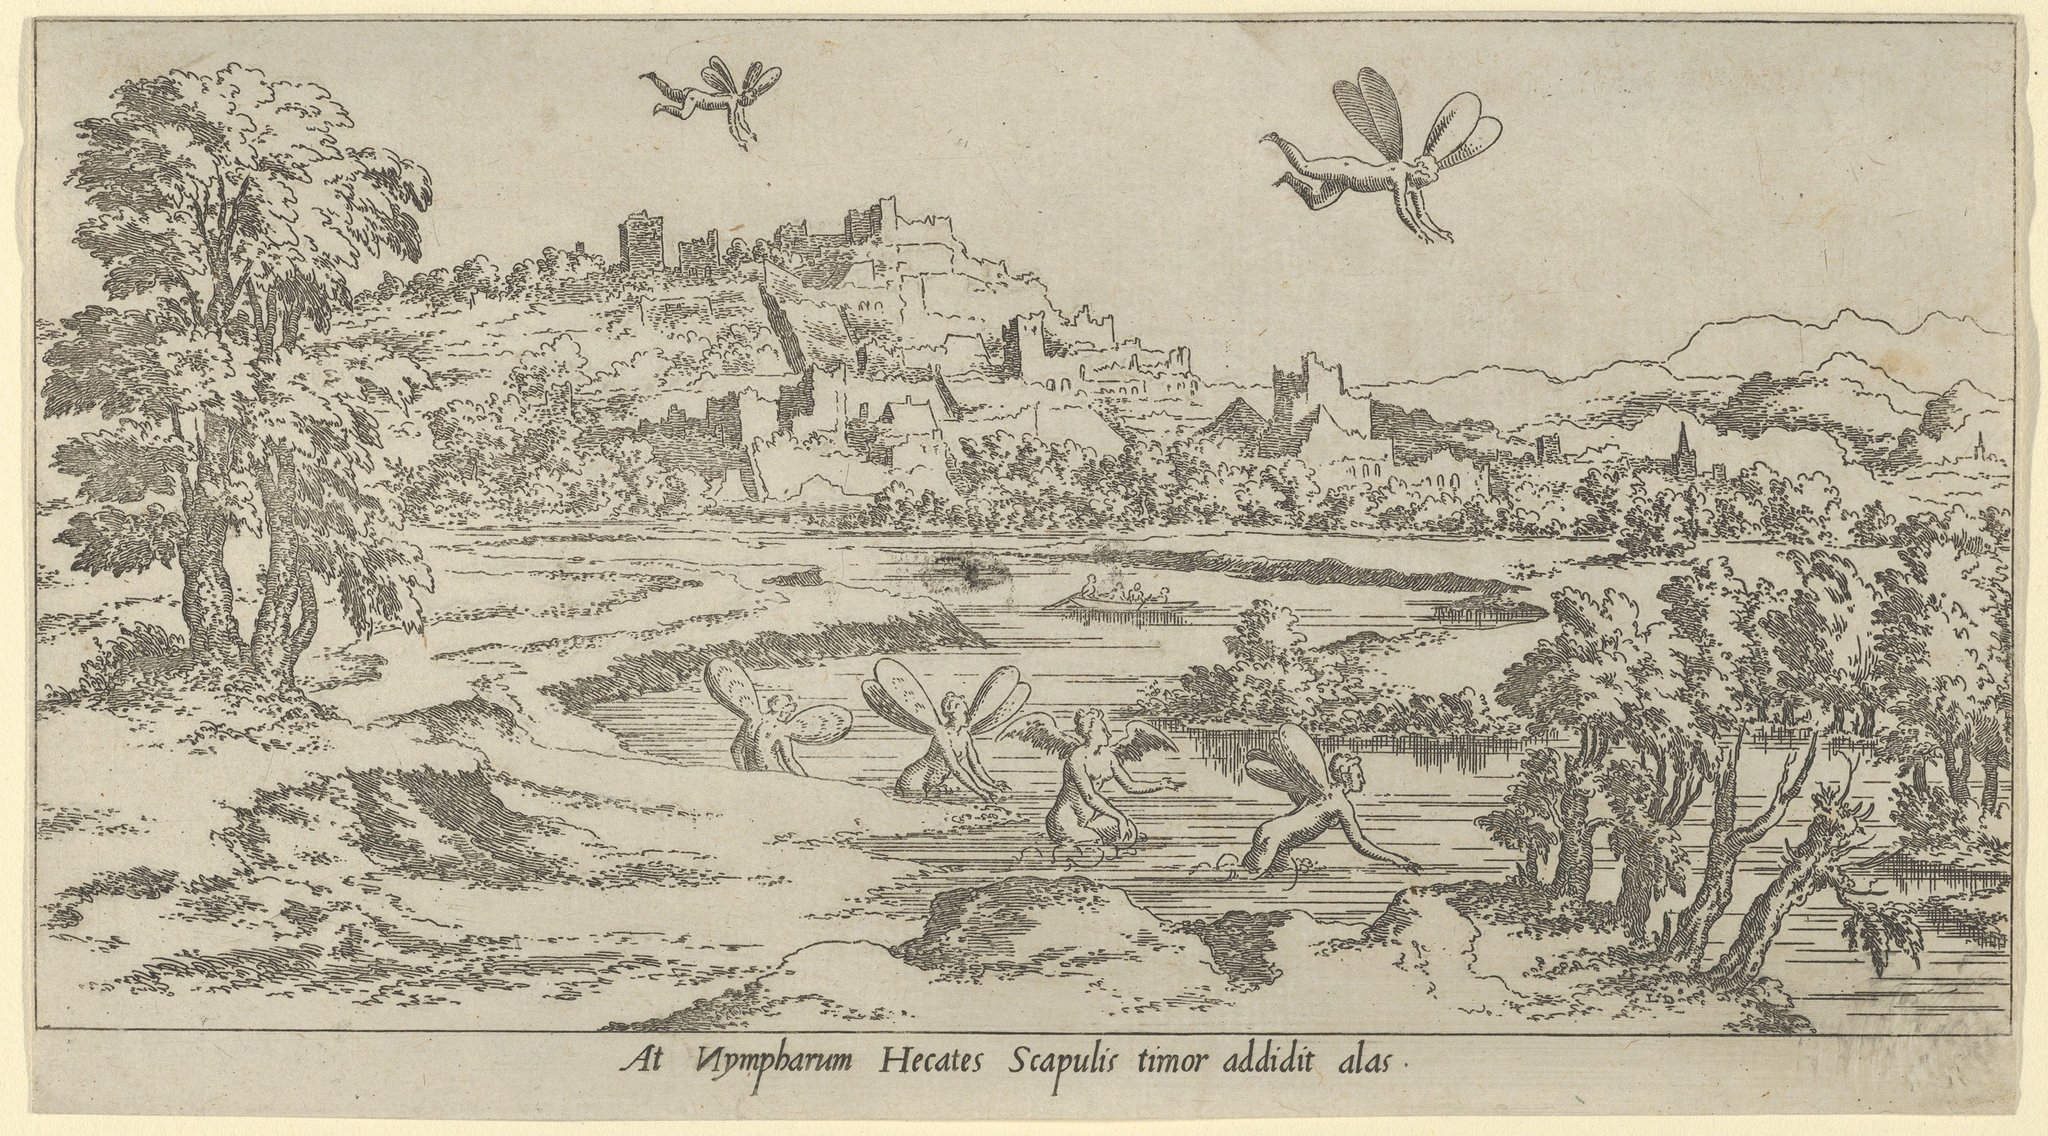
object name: print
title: At Nympharum Hecates Scapulis Timor Addidit Alas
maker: léon davent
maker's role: artist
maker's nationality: french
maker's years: 1540-1556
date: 1526-1550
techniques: etching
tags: nymphs,landscapes,trees